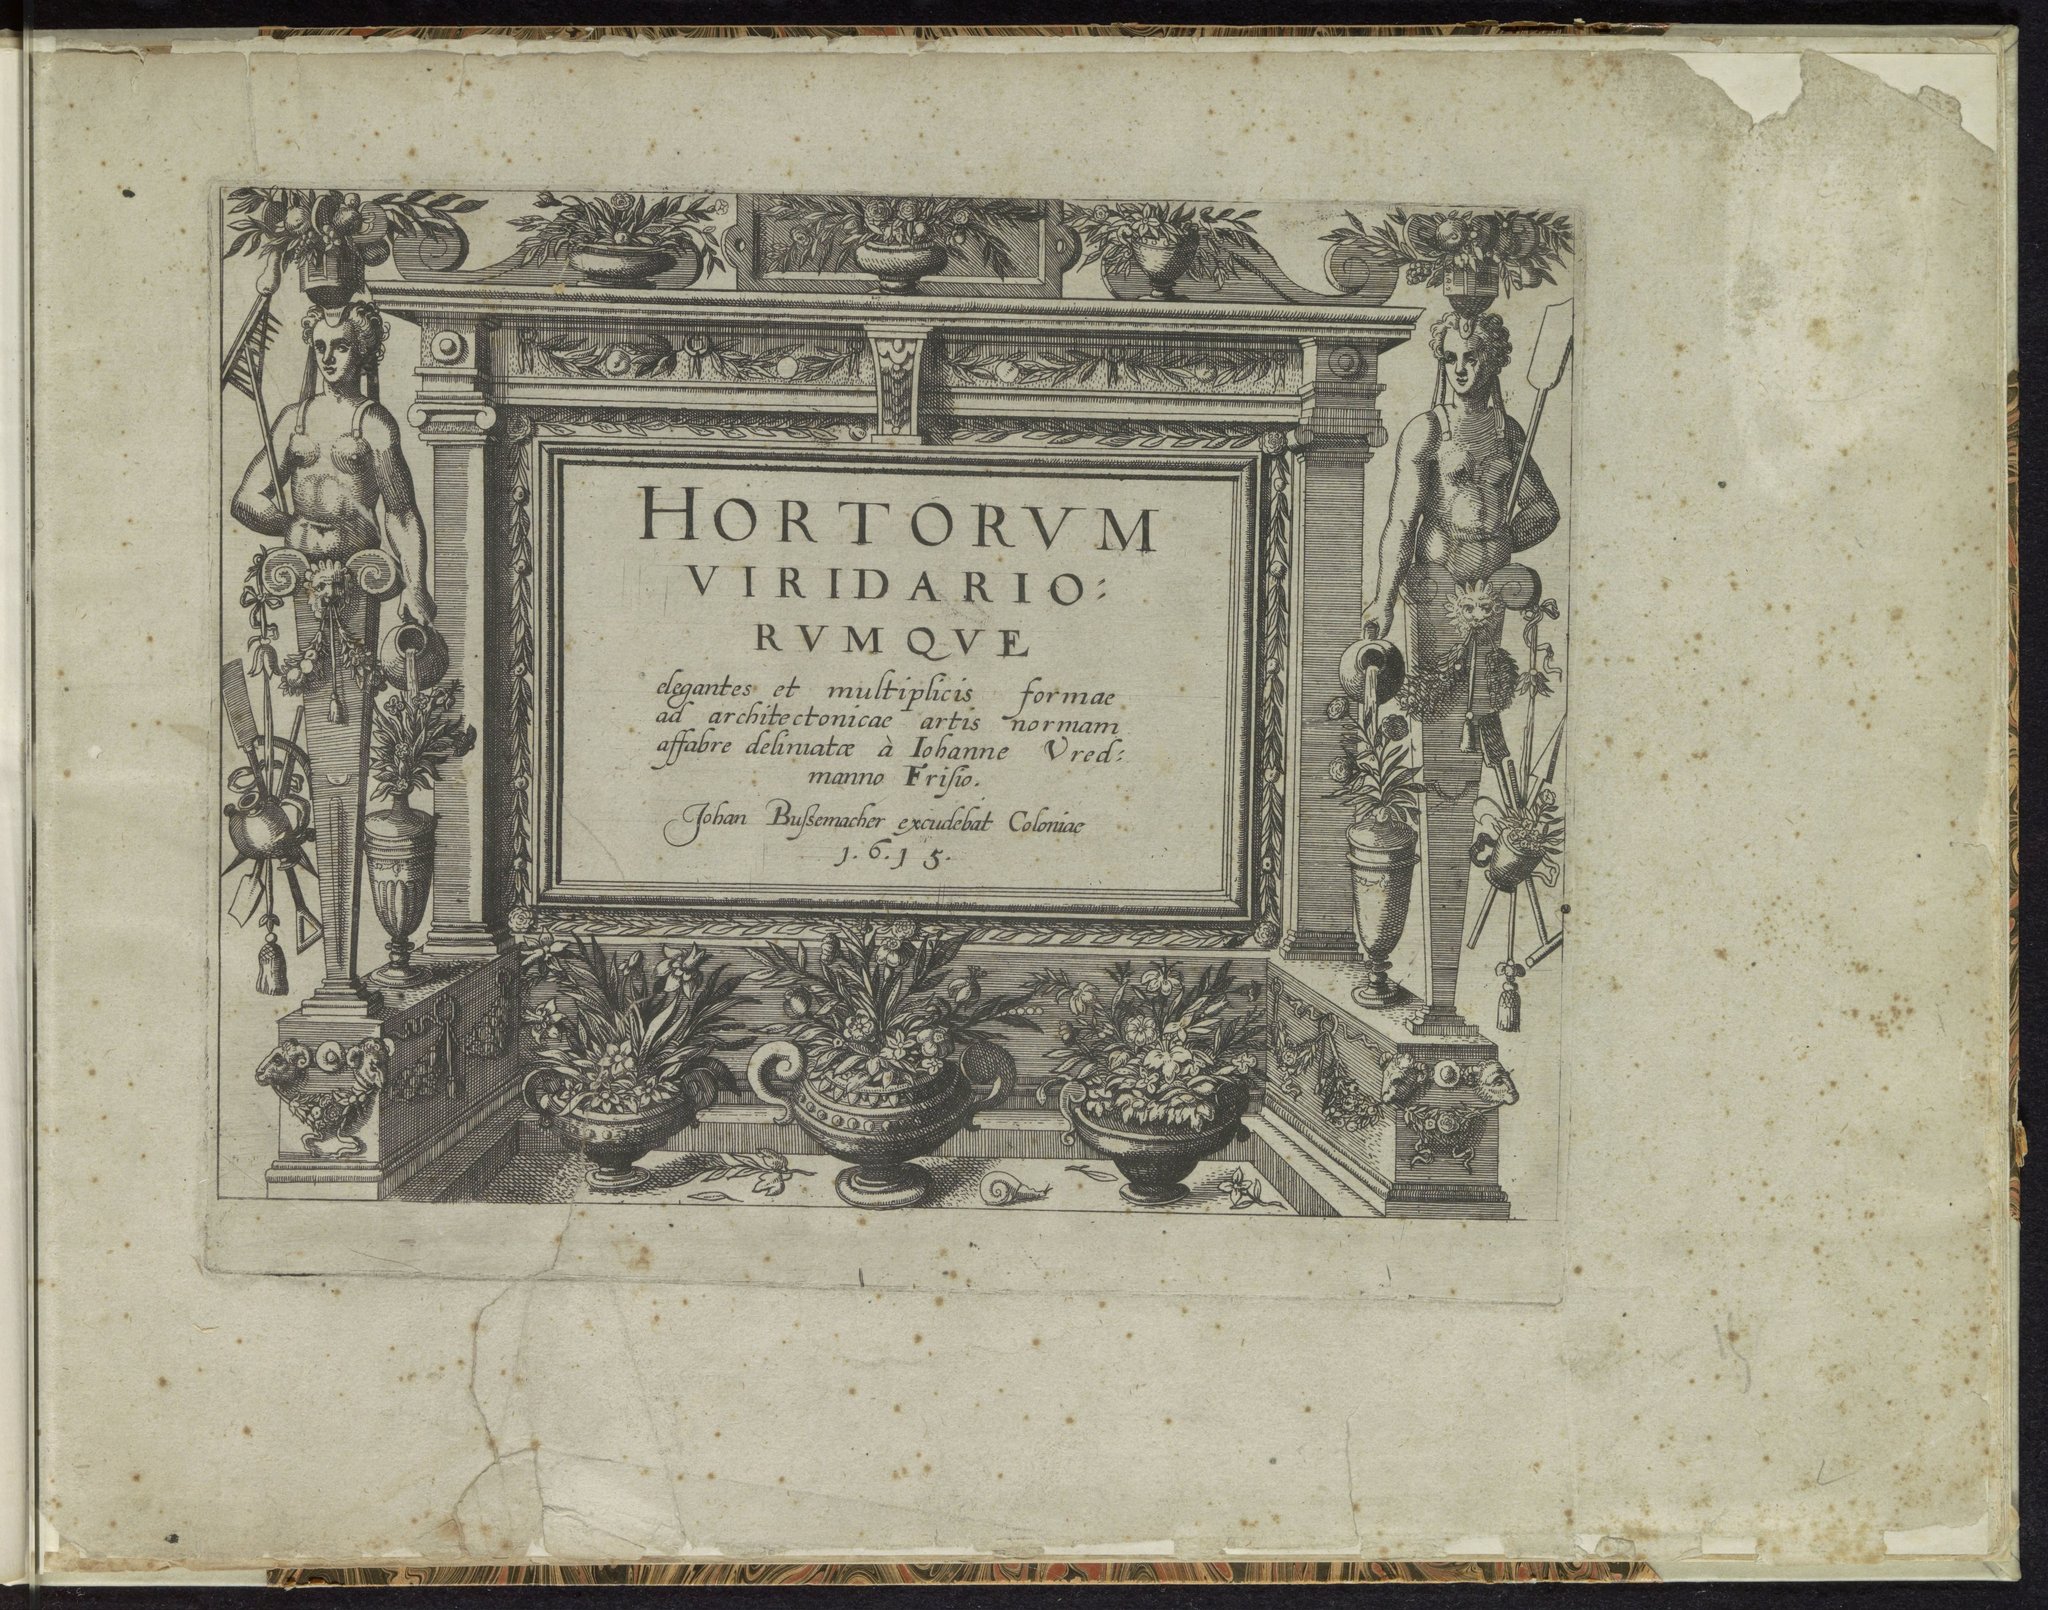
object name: titelprent, frontispice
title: Hortorum Viridariorumque elegantes et multiplicis formae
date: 1615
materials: paper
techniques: etching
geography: cologne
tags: herms (garden ornaments), garden, gardening-tools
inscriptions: date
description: Een ornamentele plaat met de titel geflankeerd door vrouwelijke hermen met tuingereedschap. Onderaan drie vazen met bloemen en een slak. De prent maakt deel uit van een album.